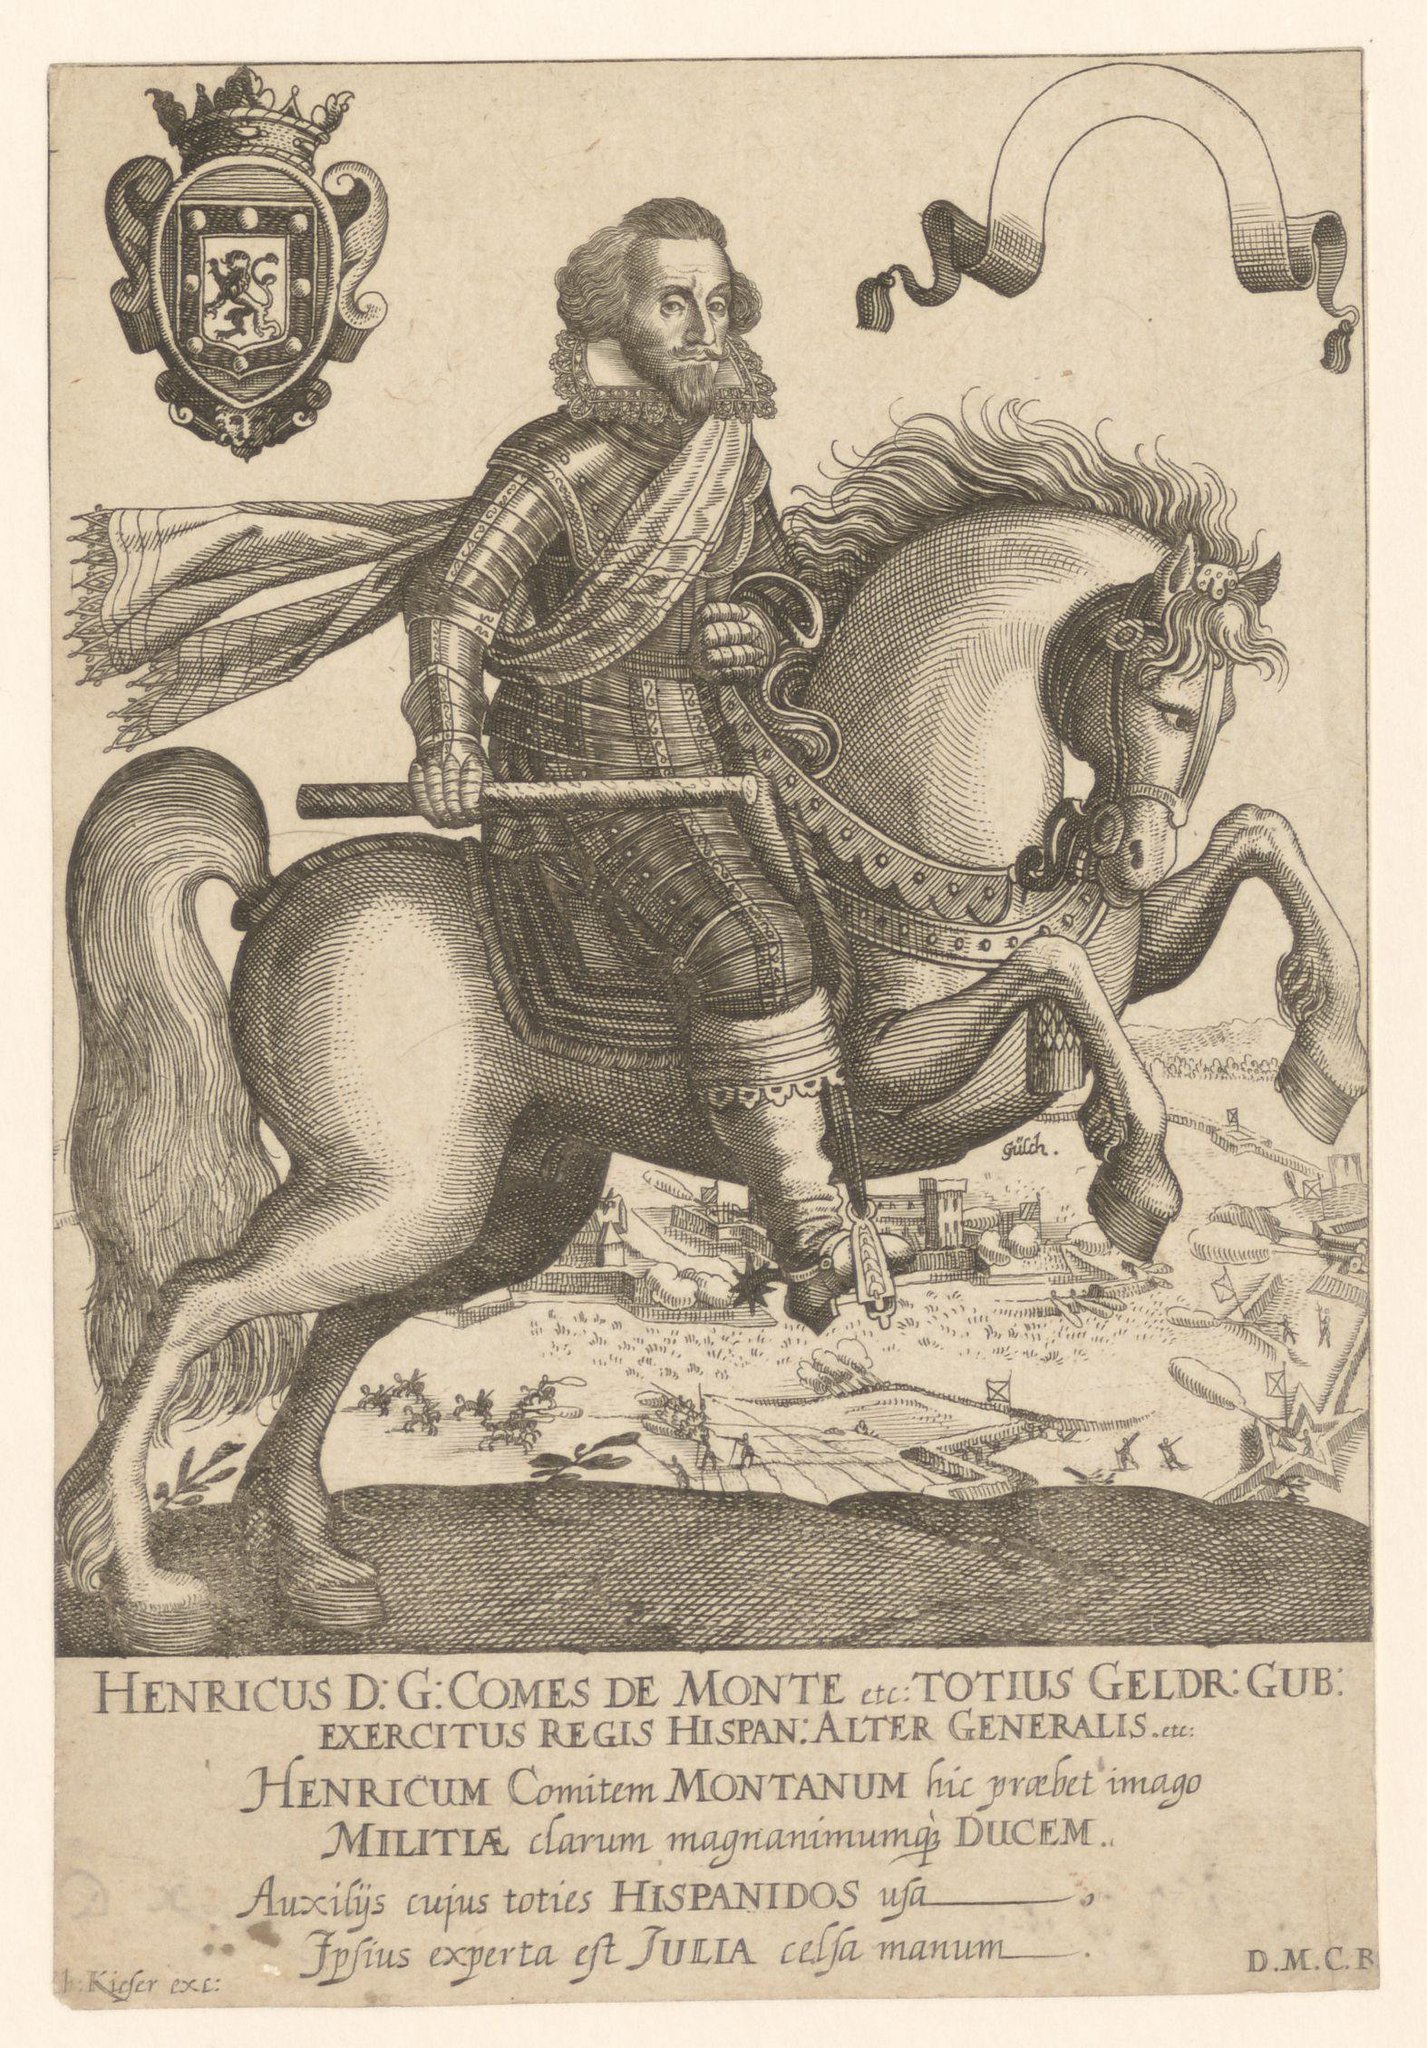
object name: print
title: Portret van Hendrik van den Bergh.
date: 1593-1625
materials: paper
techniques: engraving, etching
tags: earl, commander-in-chief, general, marshal, historical persons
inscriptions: collector's mark: Lugt 2228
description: Daniel Meisner's signatuur eindigt met zijn geboortestad Chomutov (Komotau) in Bohemen, en wordt vaak genoteerd als D.M.C.B.